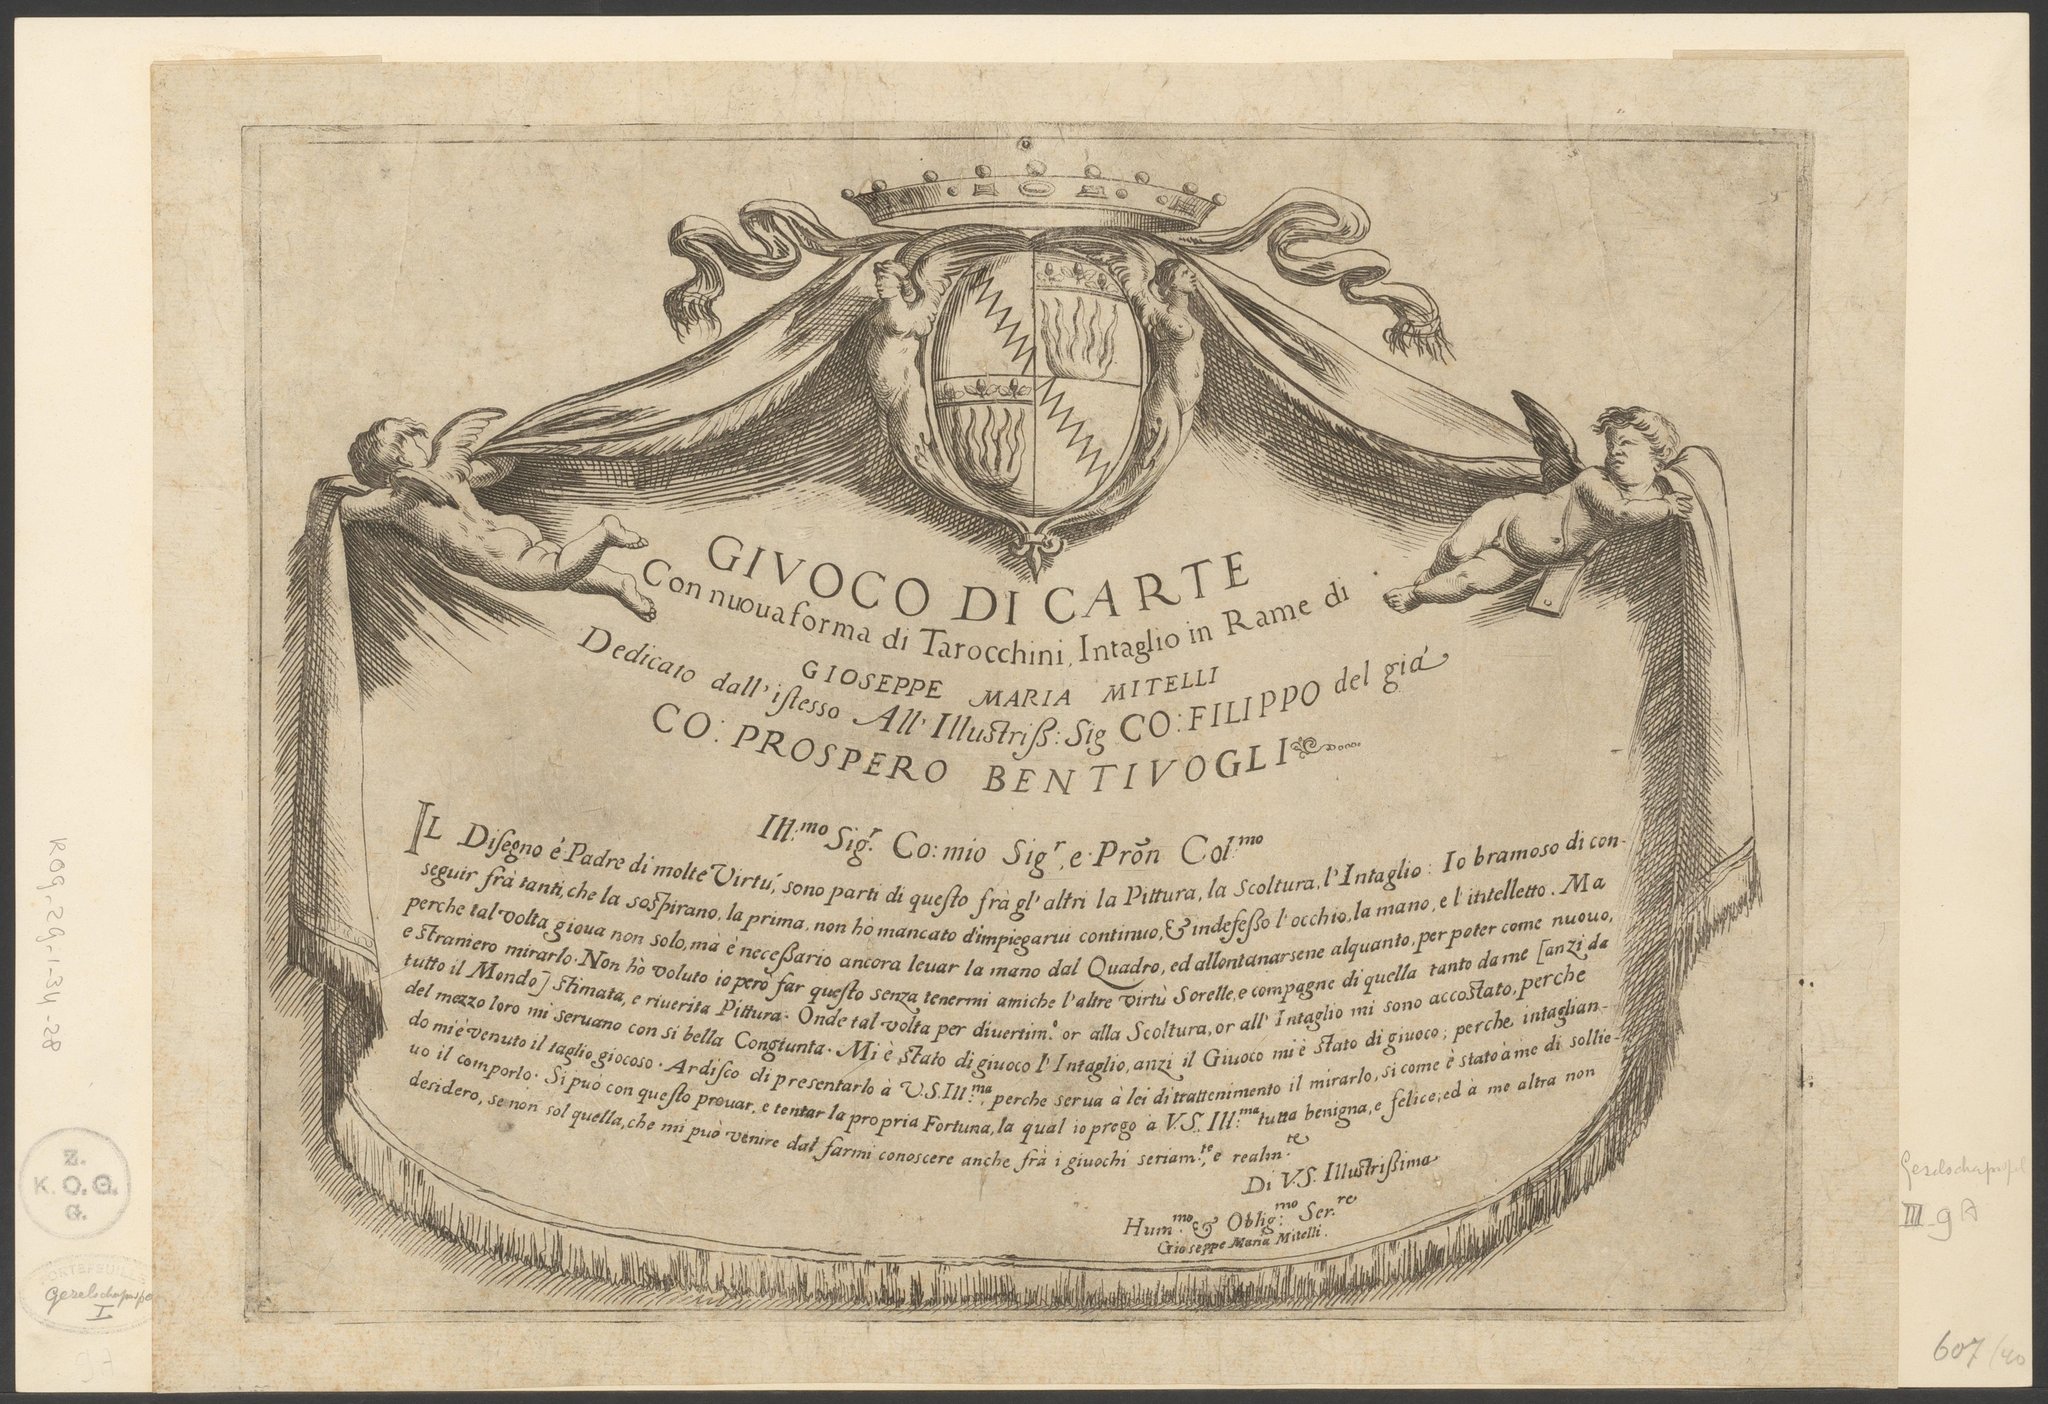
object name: titelblad, titelpagina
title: Giuoco di Carte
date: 1660-1718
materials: paper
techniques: engraving, etching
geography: bologna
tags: tarot, playing-cards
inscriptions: collector's mark: Lugt 1641, collector's mark